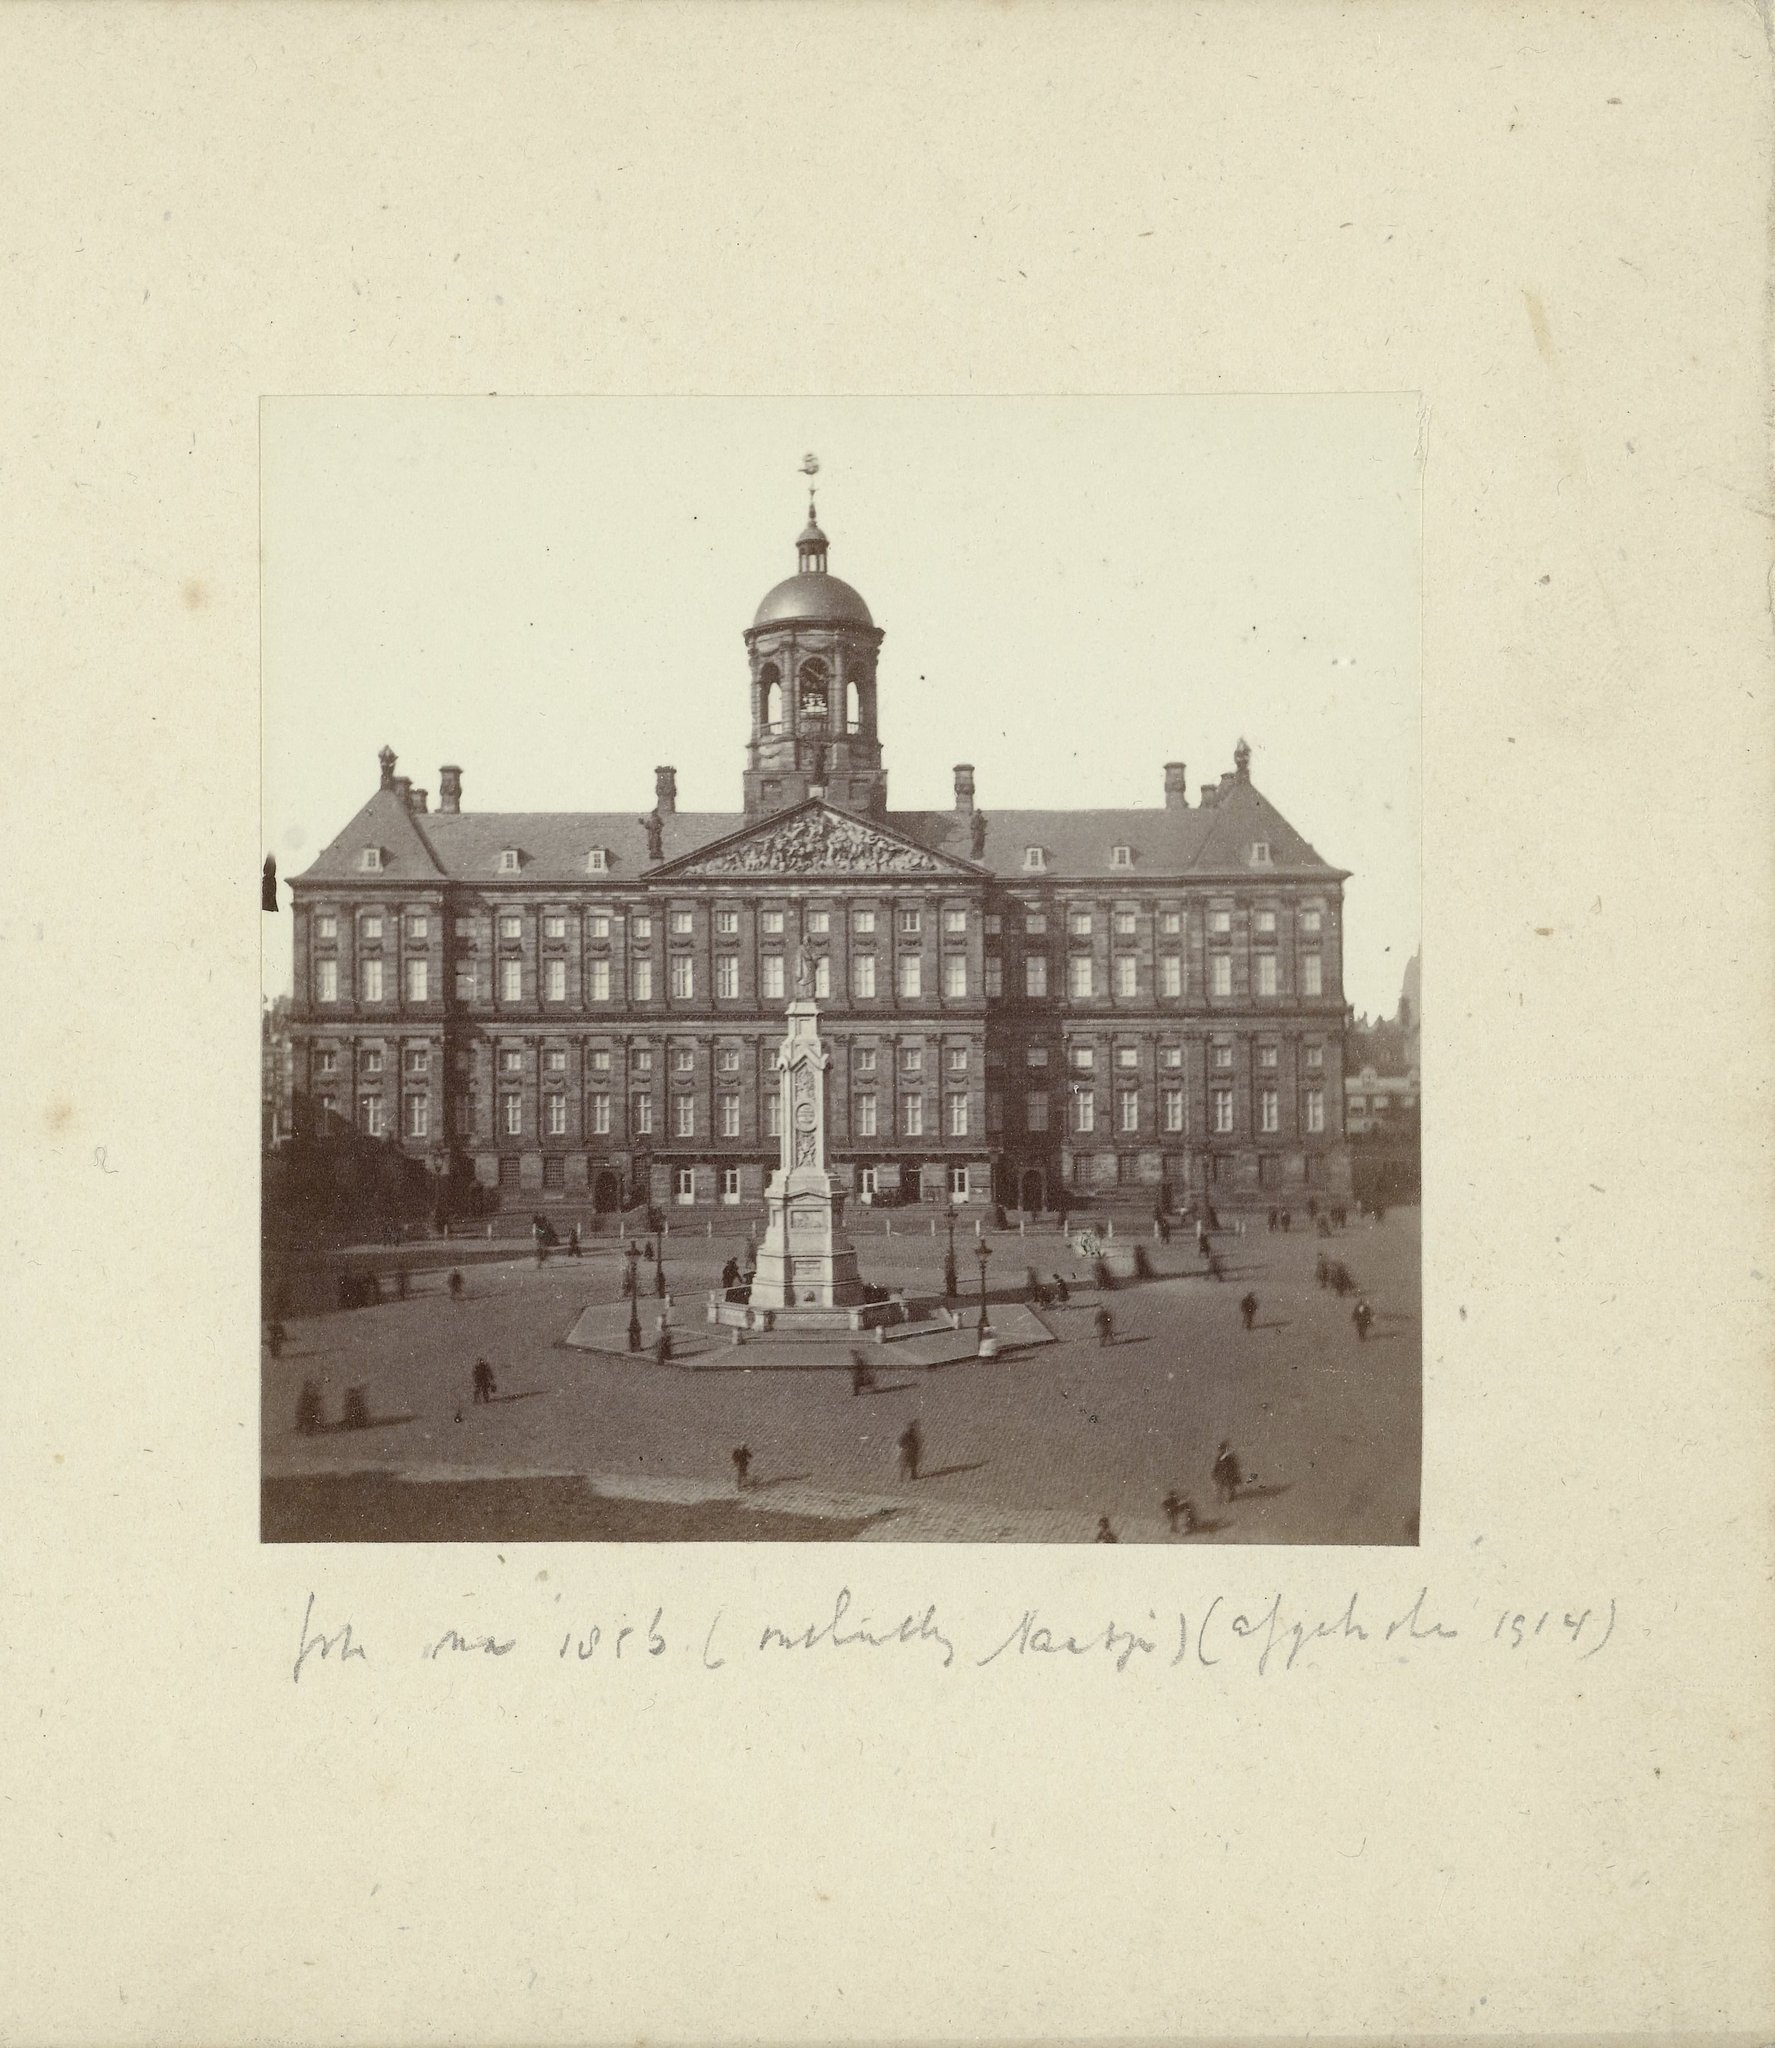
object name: photograph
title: Het paleis op den Dam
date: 1860-1875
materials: cardboard, paper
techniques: albumen print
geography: amsterdam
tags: square, place, circus, etc., palace, monument, statue, royal palace of amsterdam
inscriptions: caption: ‘foto na 1856 (.. Naatje) (afgebroken 1914)’